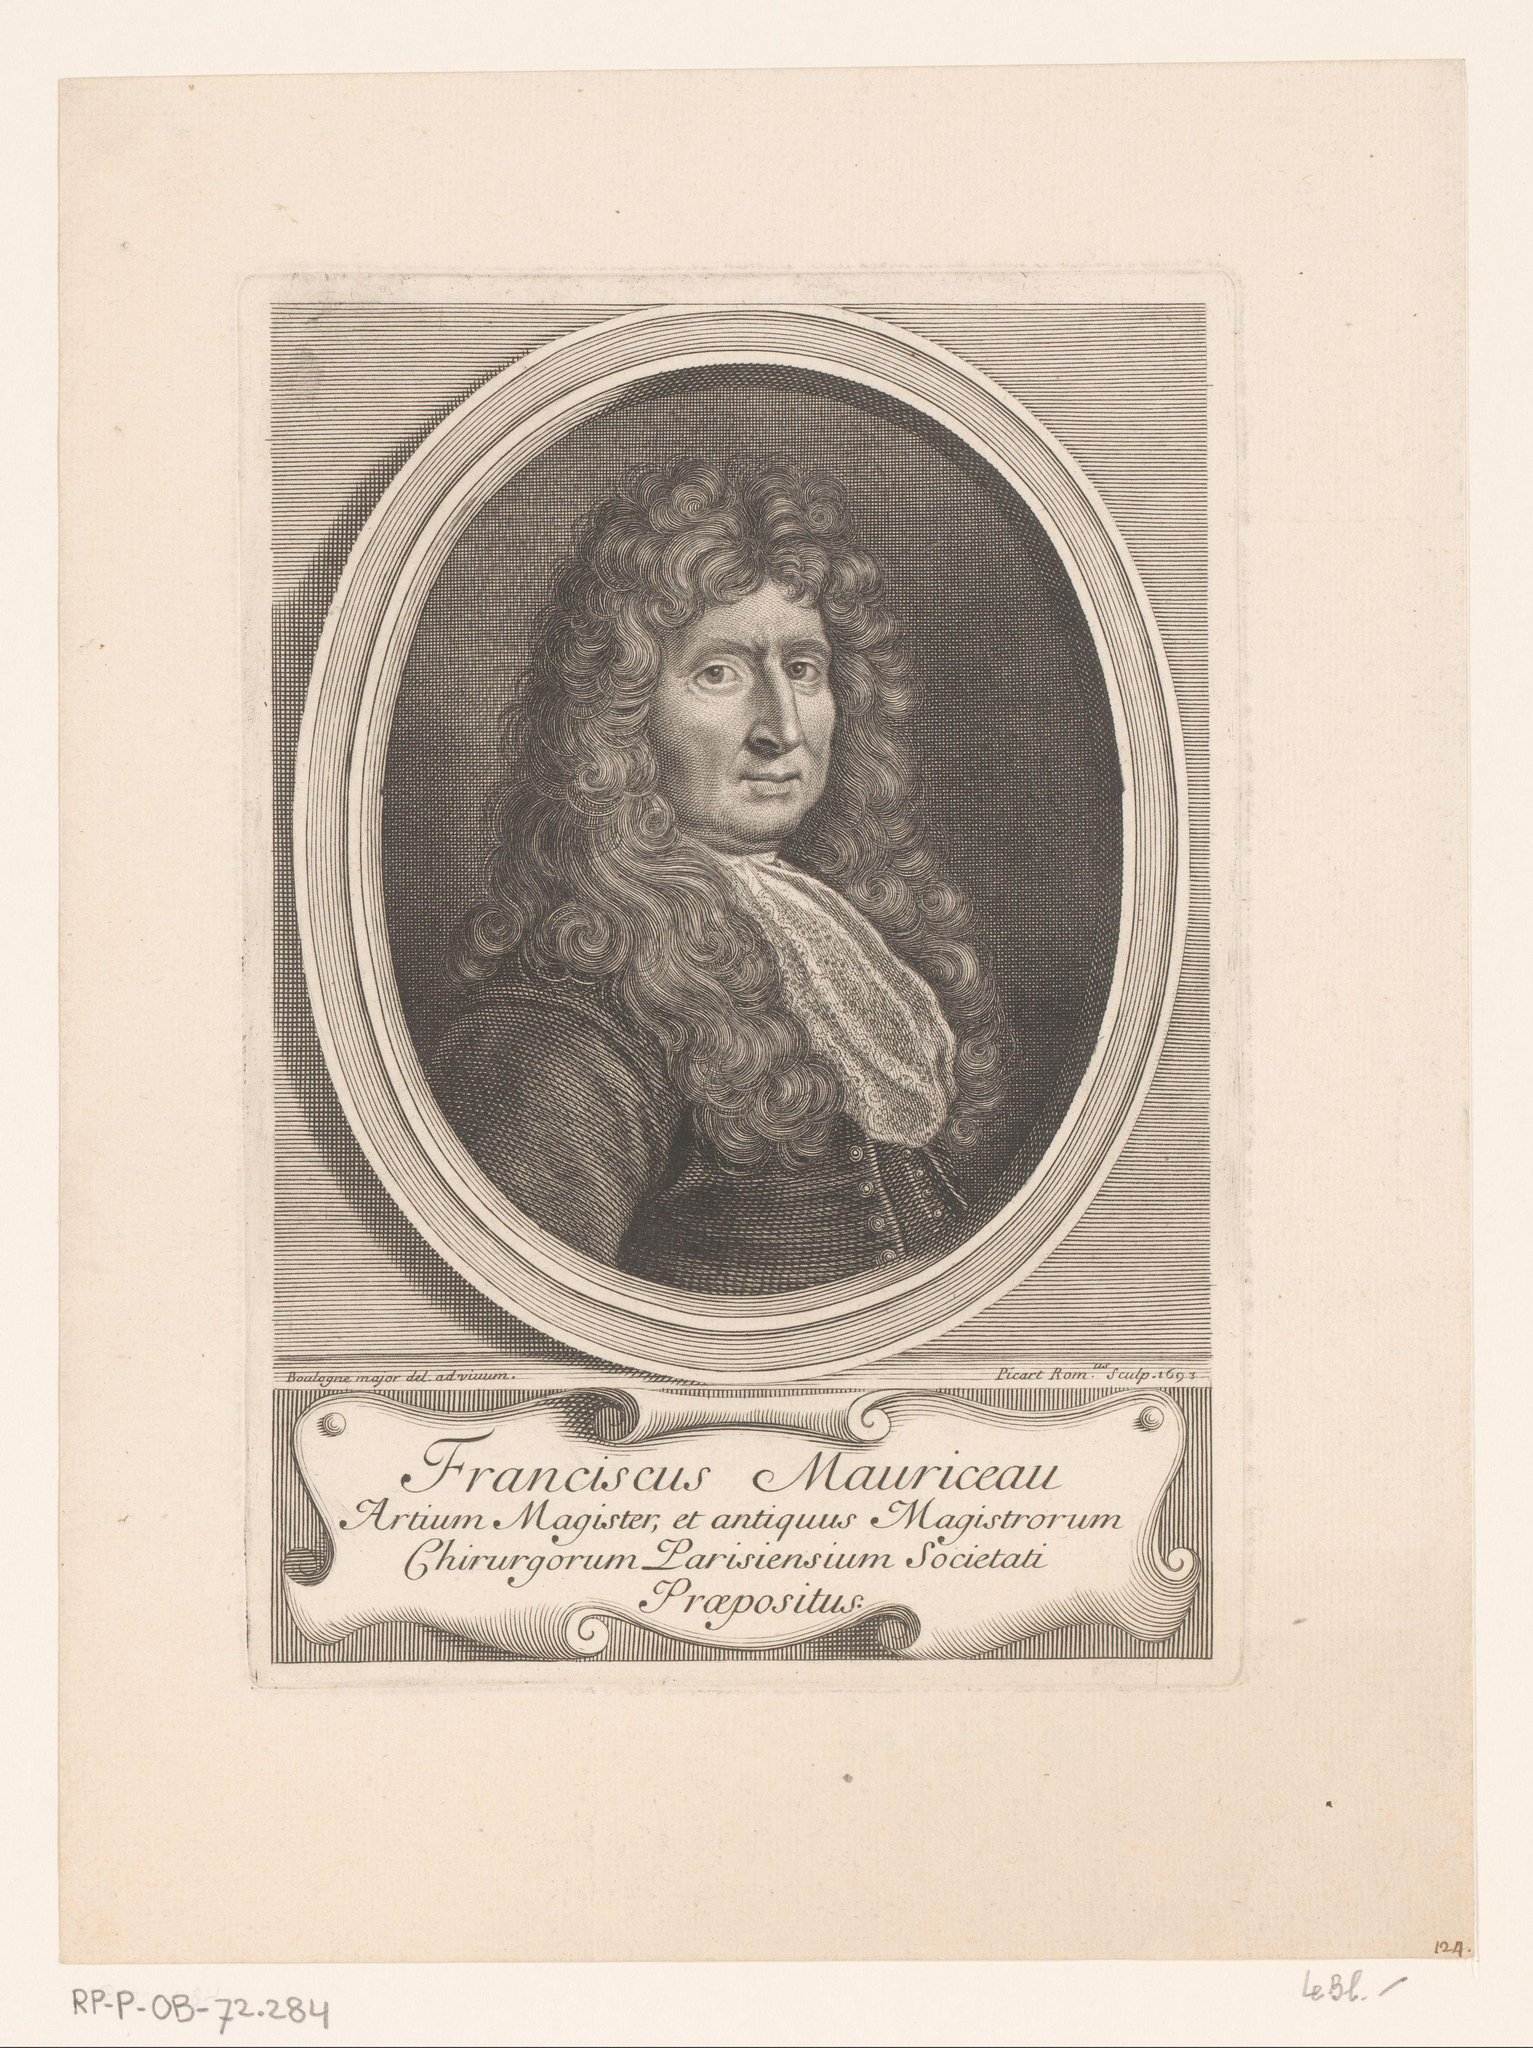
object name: print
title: Portret van François Mauriceau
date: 1691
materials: paper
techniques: engraving, etching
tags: paris, gynaecology, obstetrics, historical persons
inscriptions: collector's mark: Lugt 2228